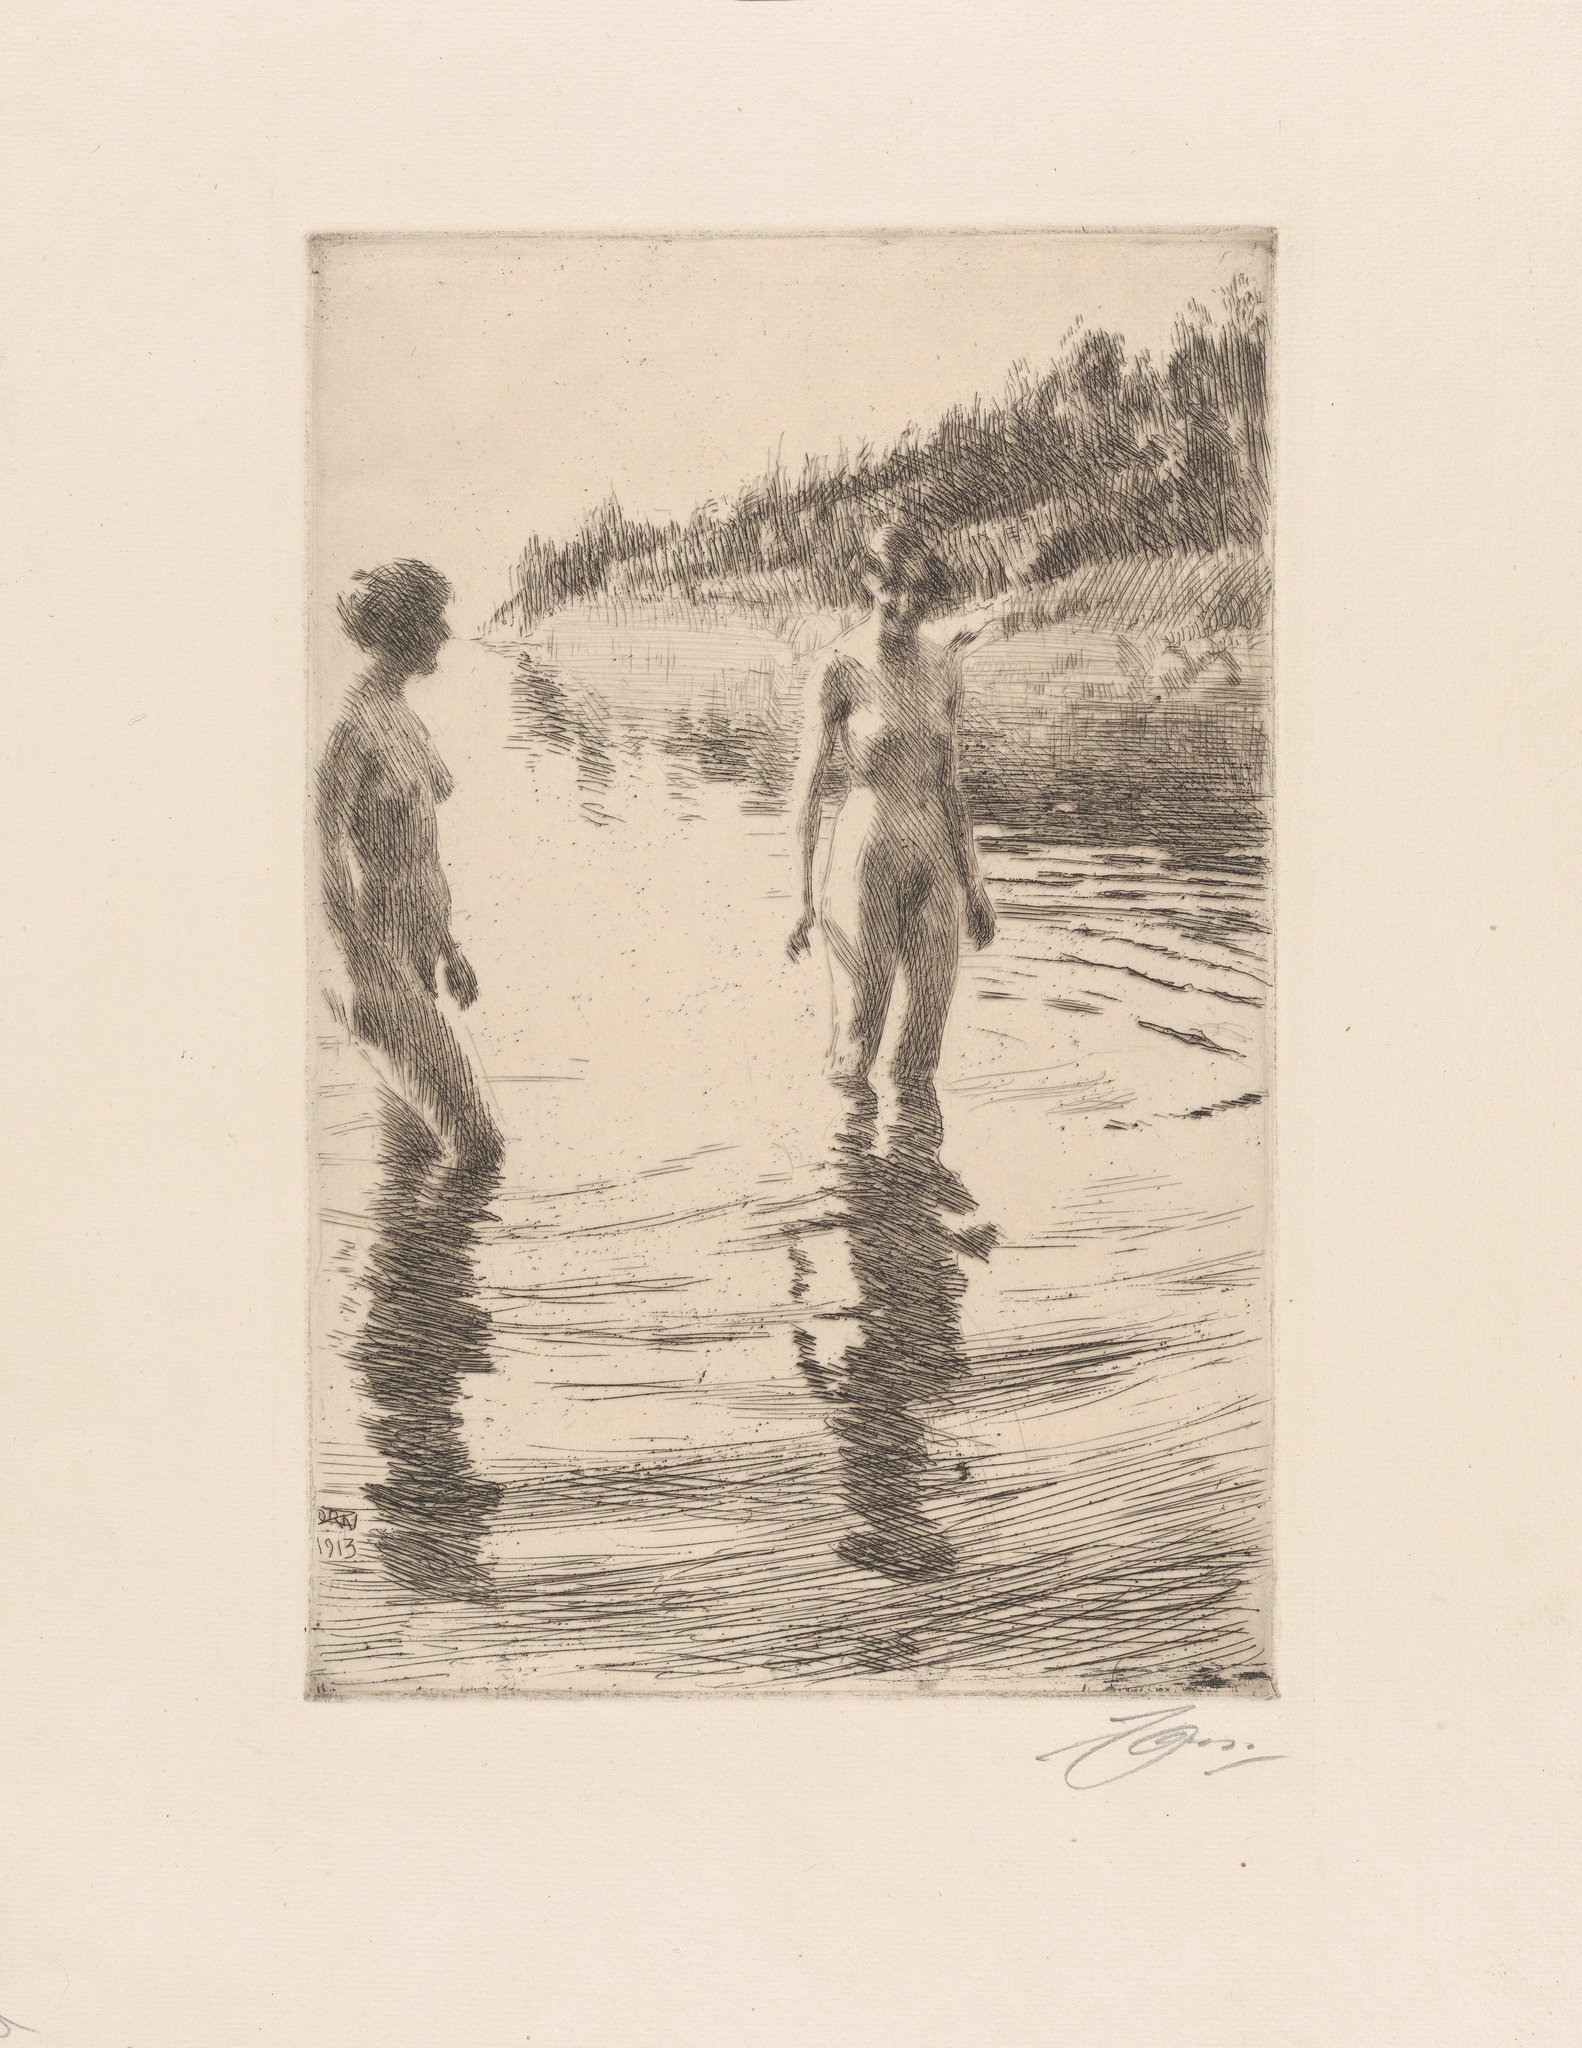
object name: print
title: Shallow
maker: anders zorn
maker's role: artist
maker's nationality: swedish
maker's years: 1860-1920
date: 1913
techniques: etching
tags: female nudes